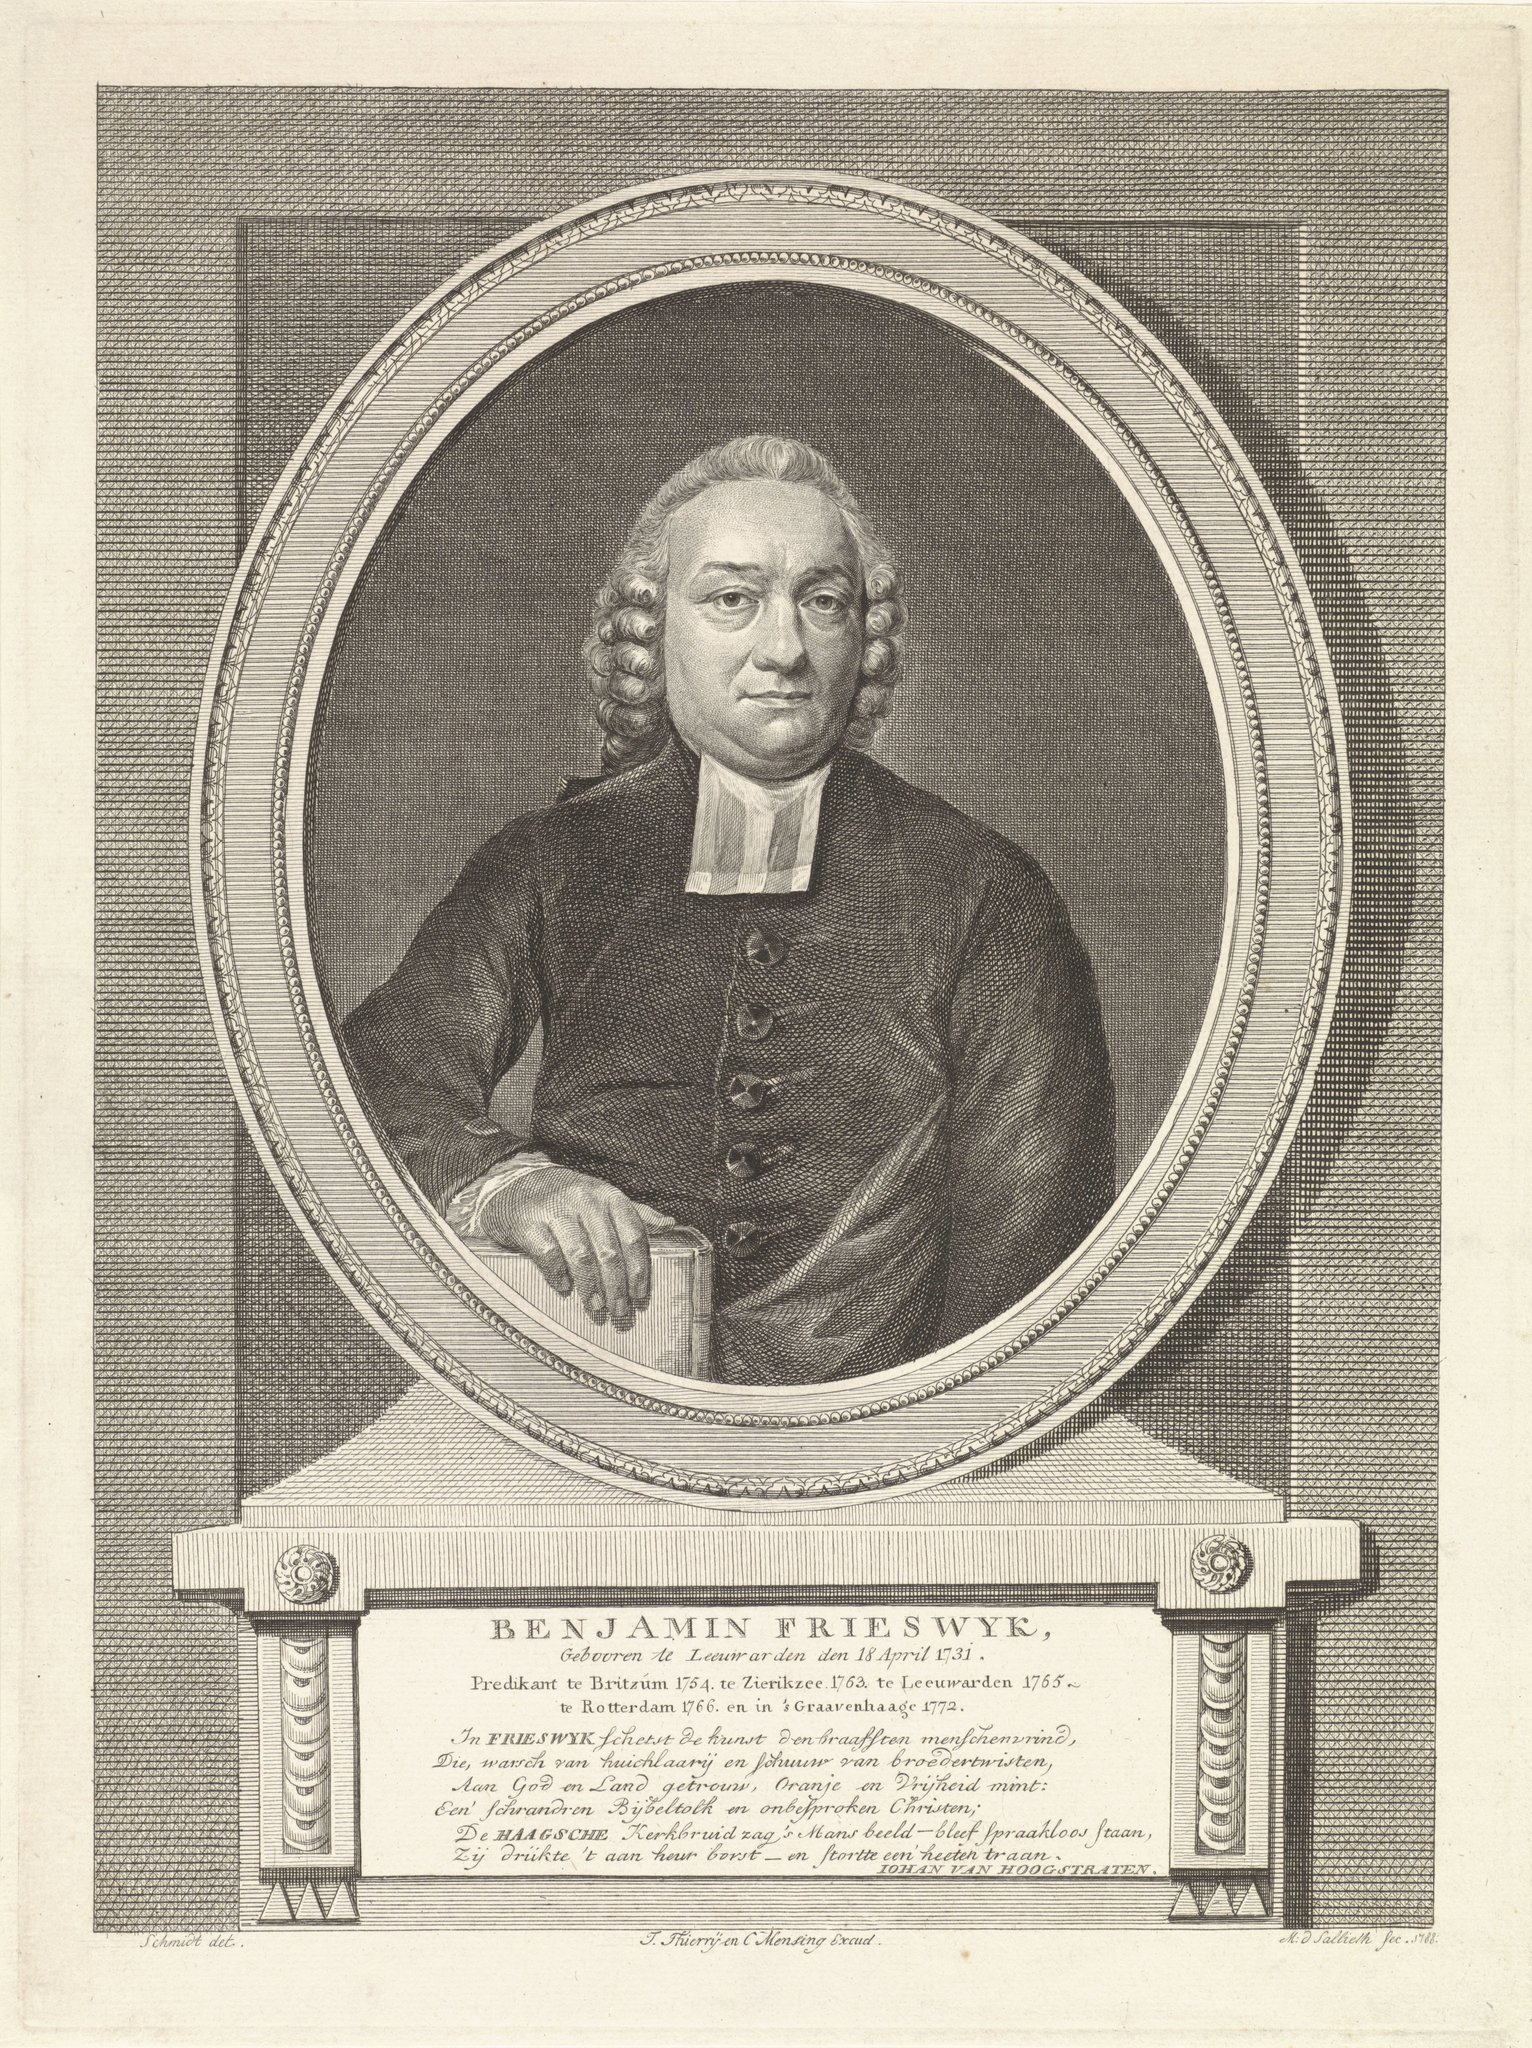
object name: print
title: Portret van de predikant Benjamin Frieswijk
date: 1788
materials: paper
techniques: engraving, etching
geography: the hague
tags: benjamin frieswijk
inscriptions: collector's mark: Lugt 2228